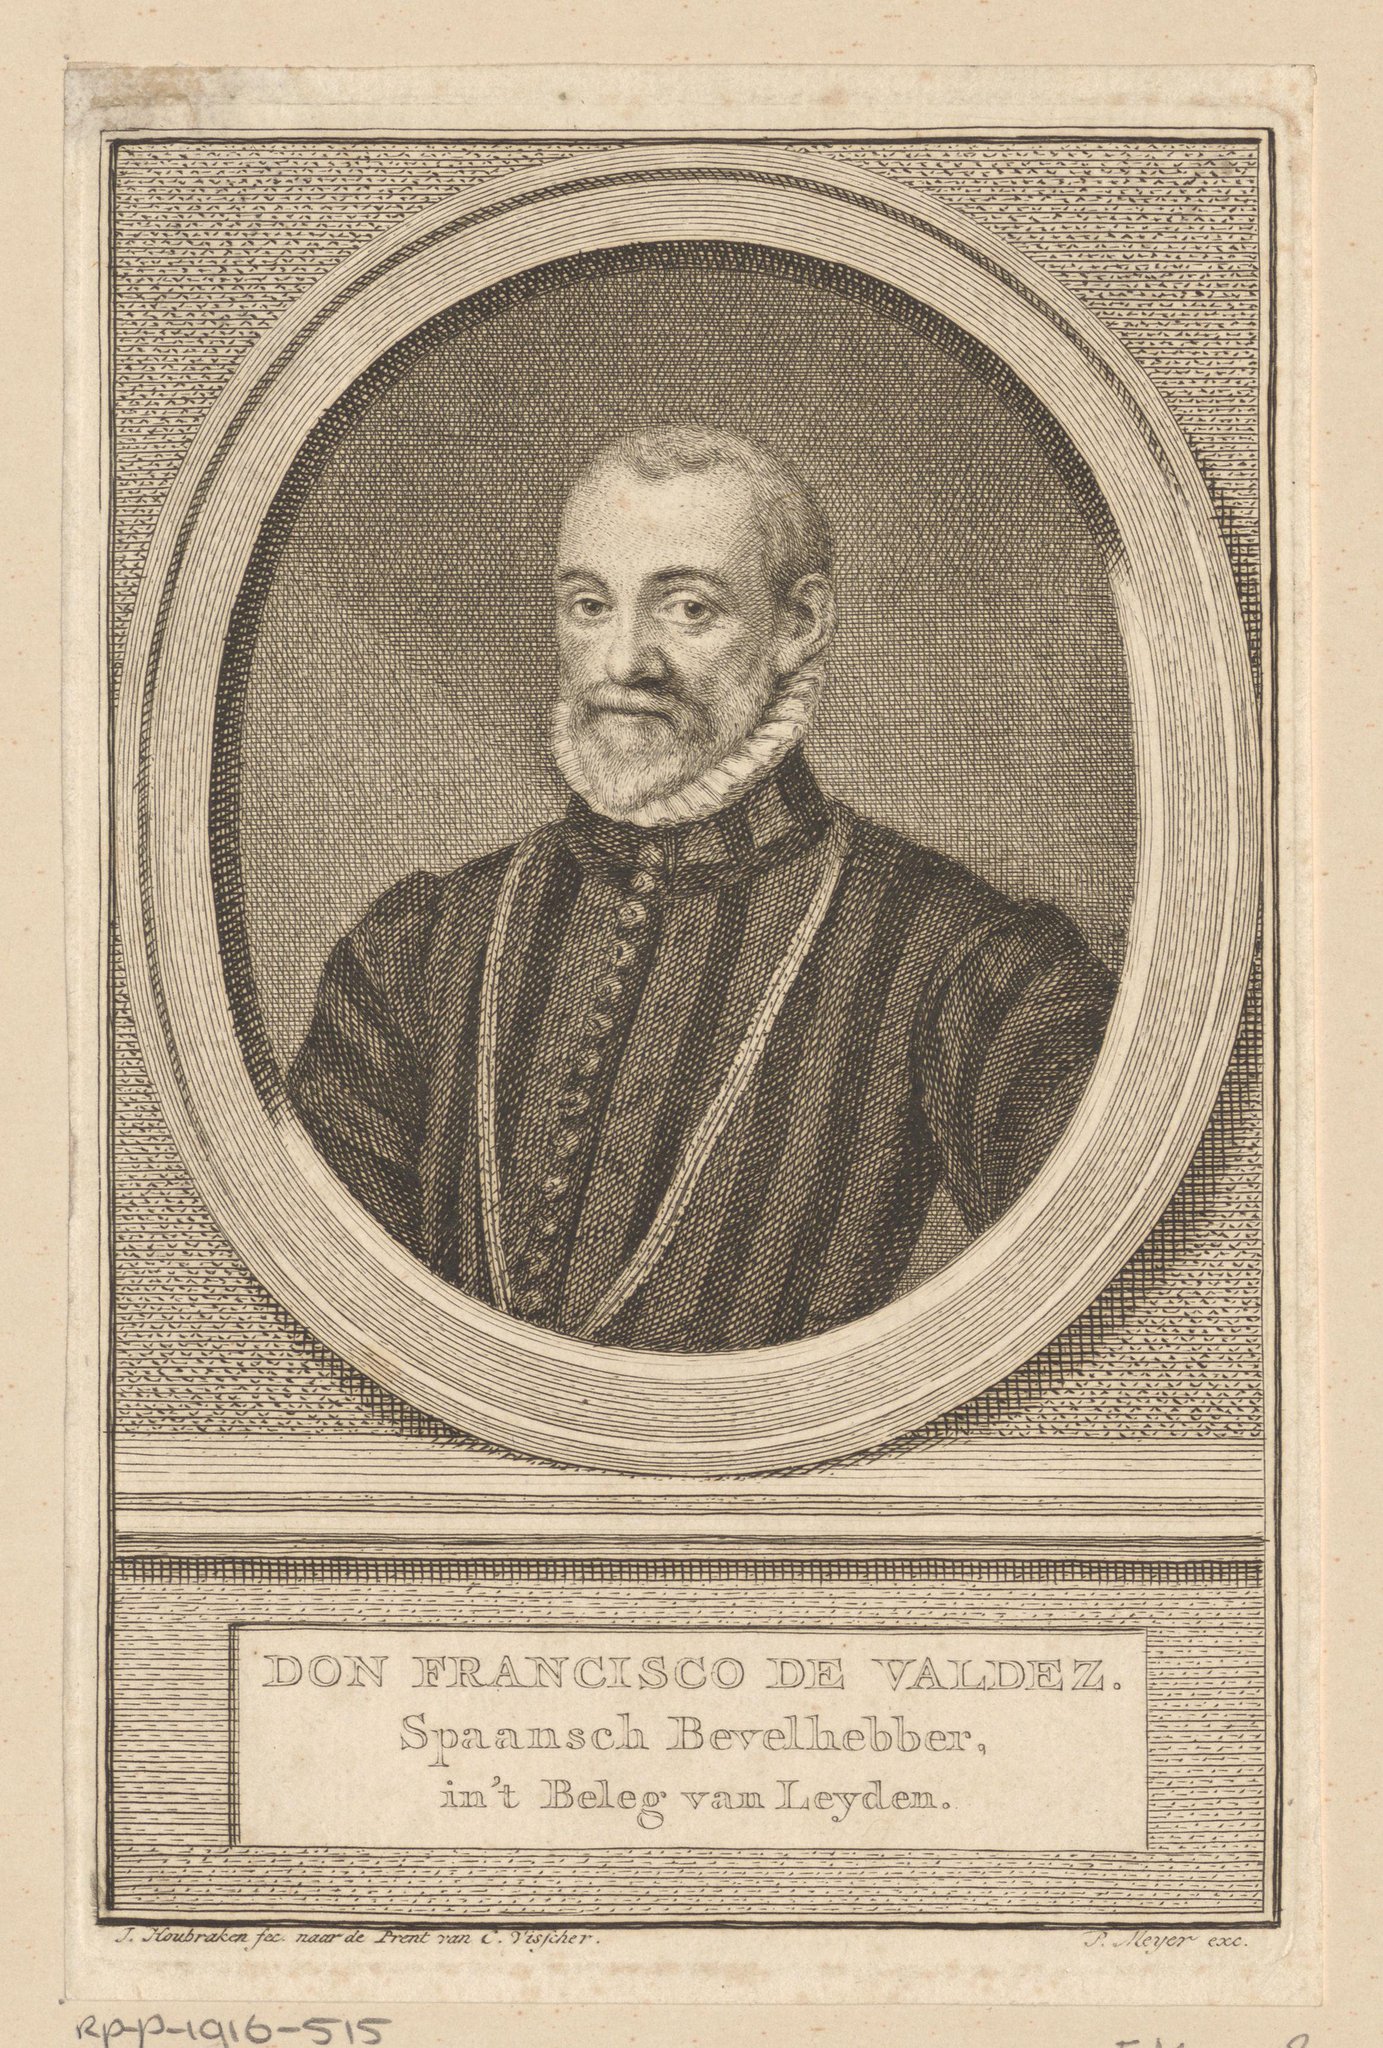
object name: print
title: Portret van Francisco de Valdez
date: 1747-1780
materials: paper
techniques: engraving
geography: amsterdam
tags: commander-in-chief, general, marshal, historical persons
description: Prent mogelijk uit: Het verheerlijkt Leyden bij het tweede eeuwgetijde van deszelfs heuchlijk ontzet (...). Leiden: Hendrik Coster en Heyligert & Hoogenstraaten in Comp., 1774.